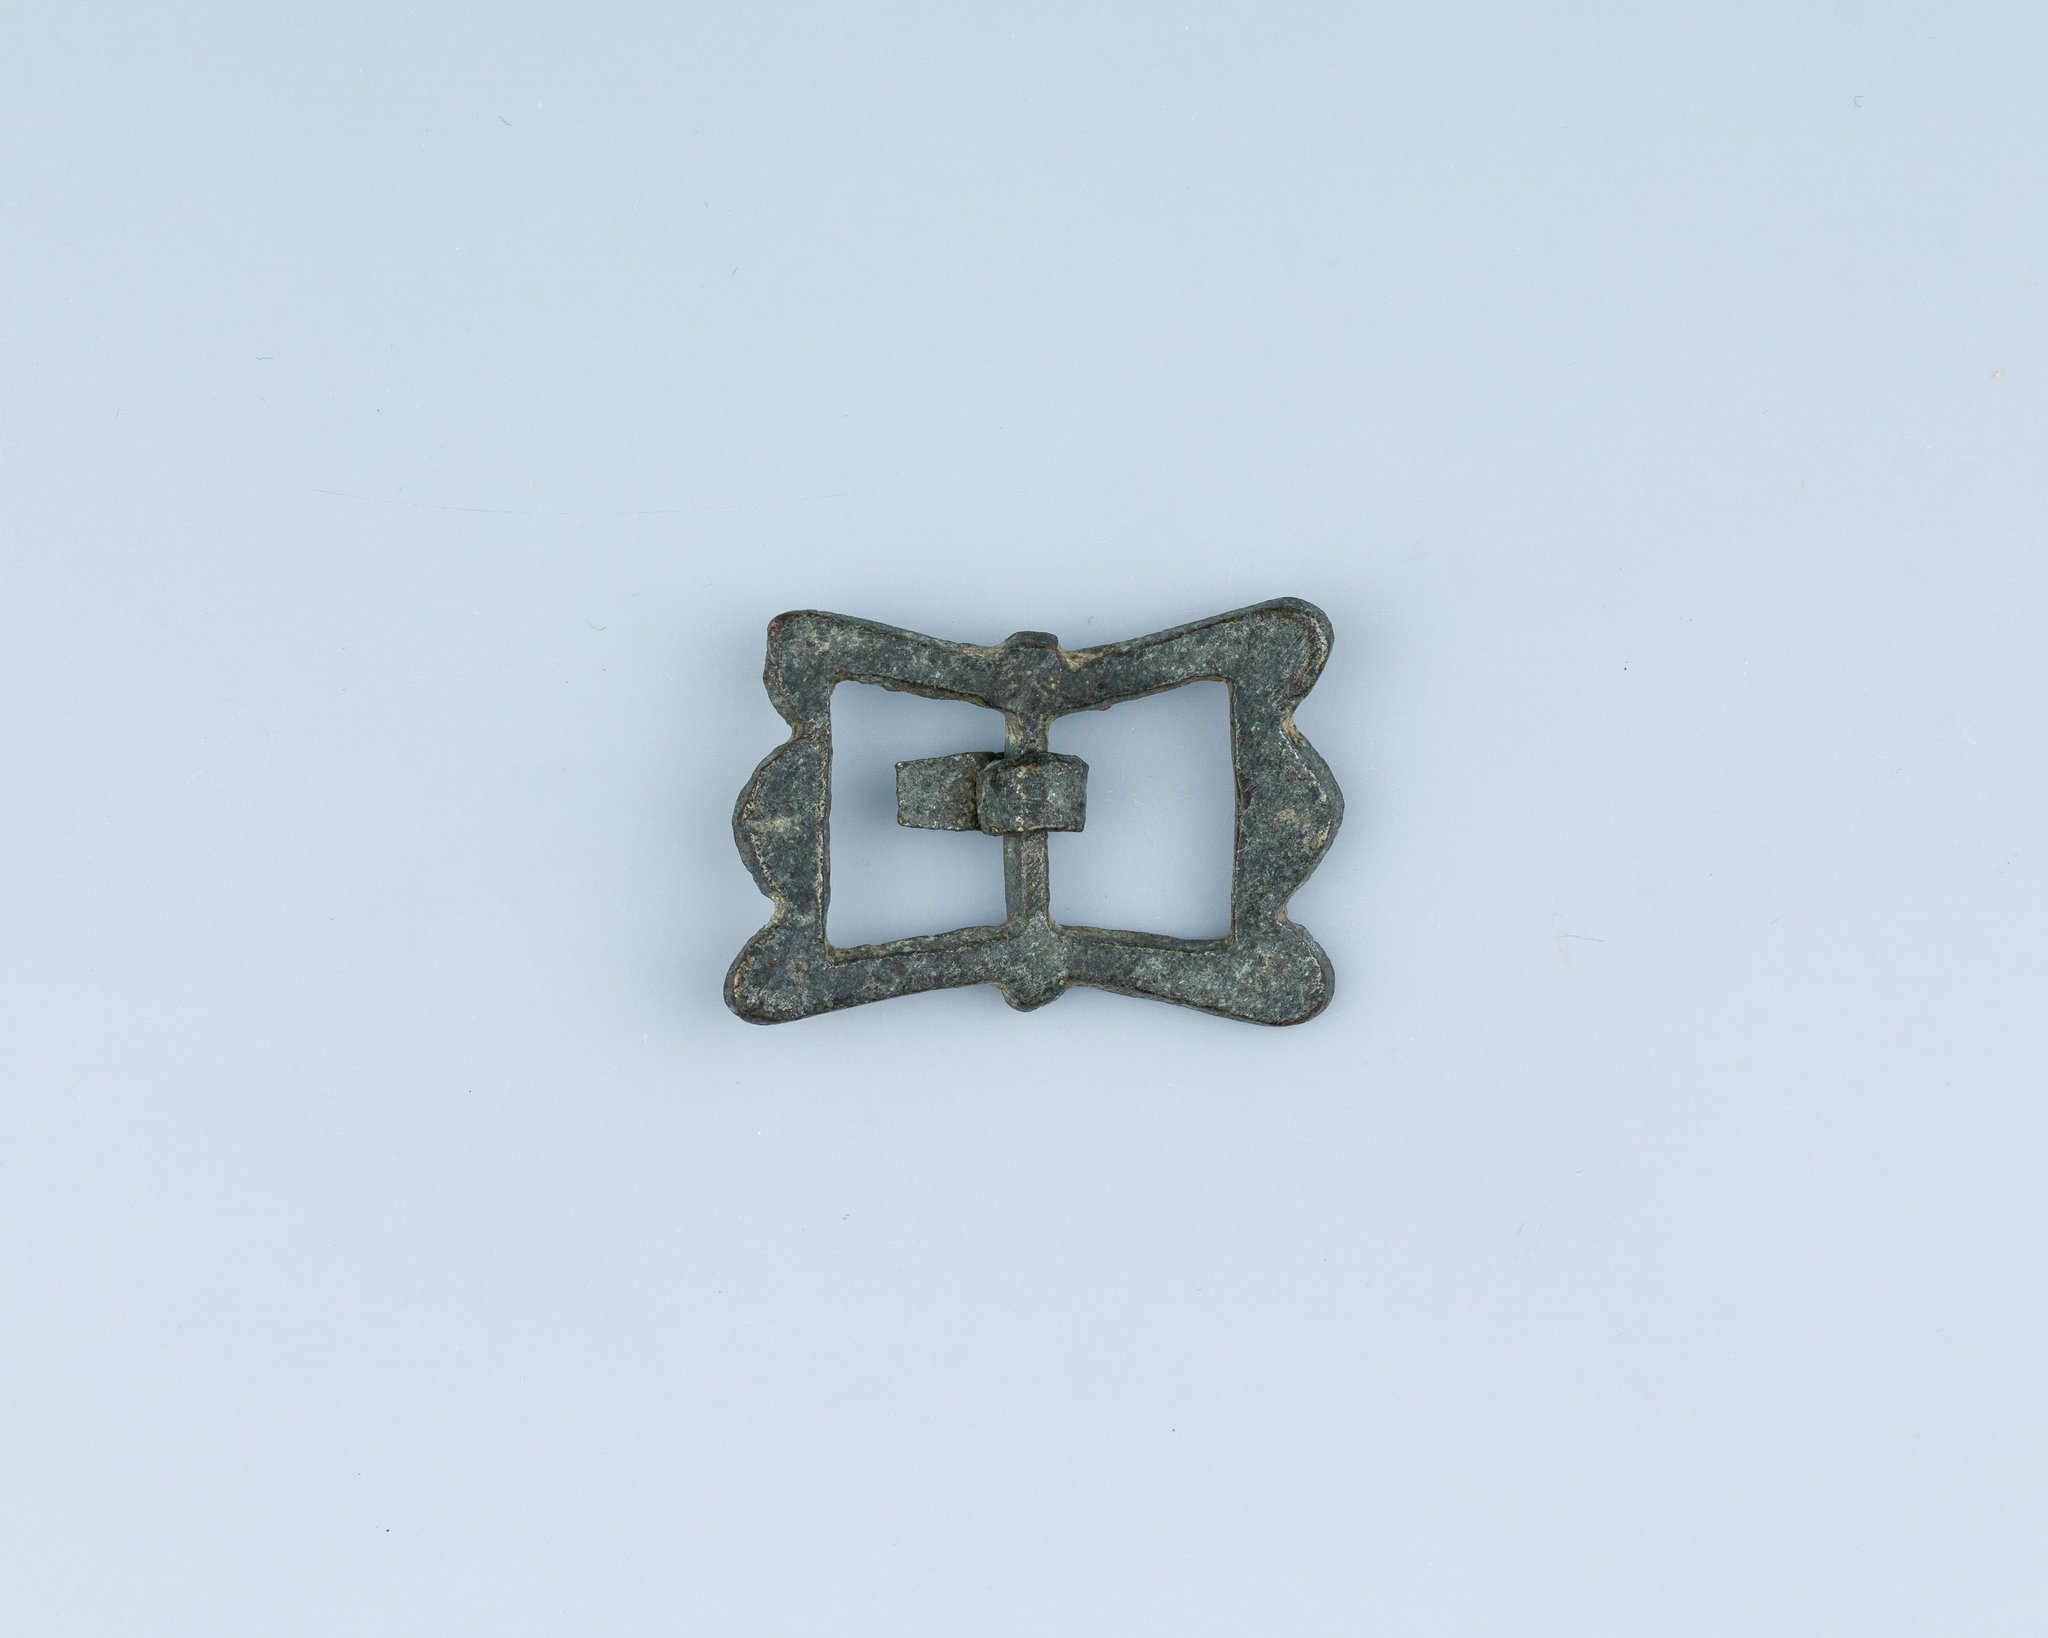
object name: buckle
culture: european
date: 1401-1600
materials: brass, patina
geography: germany